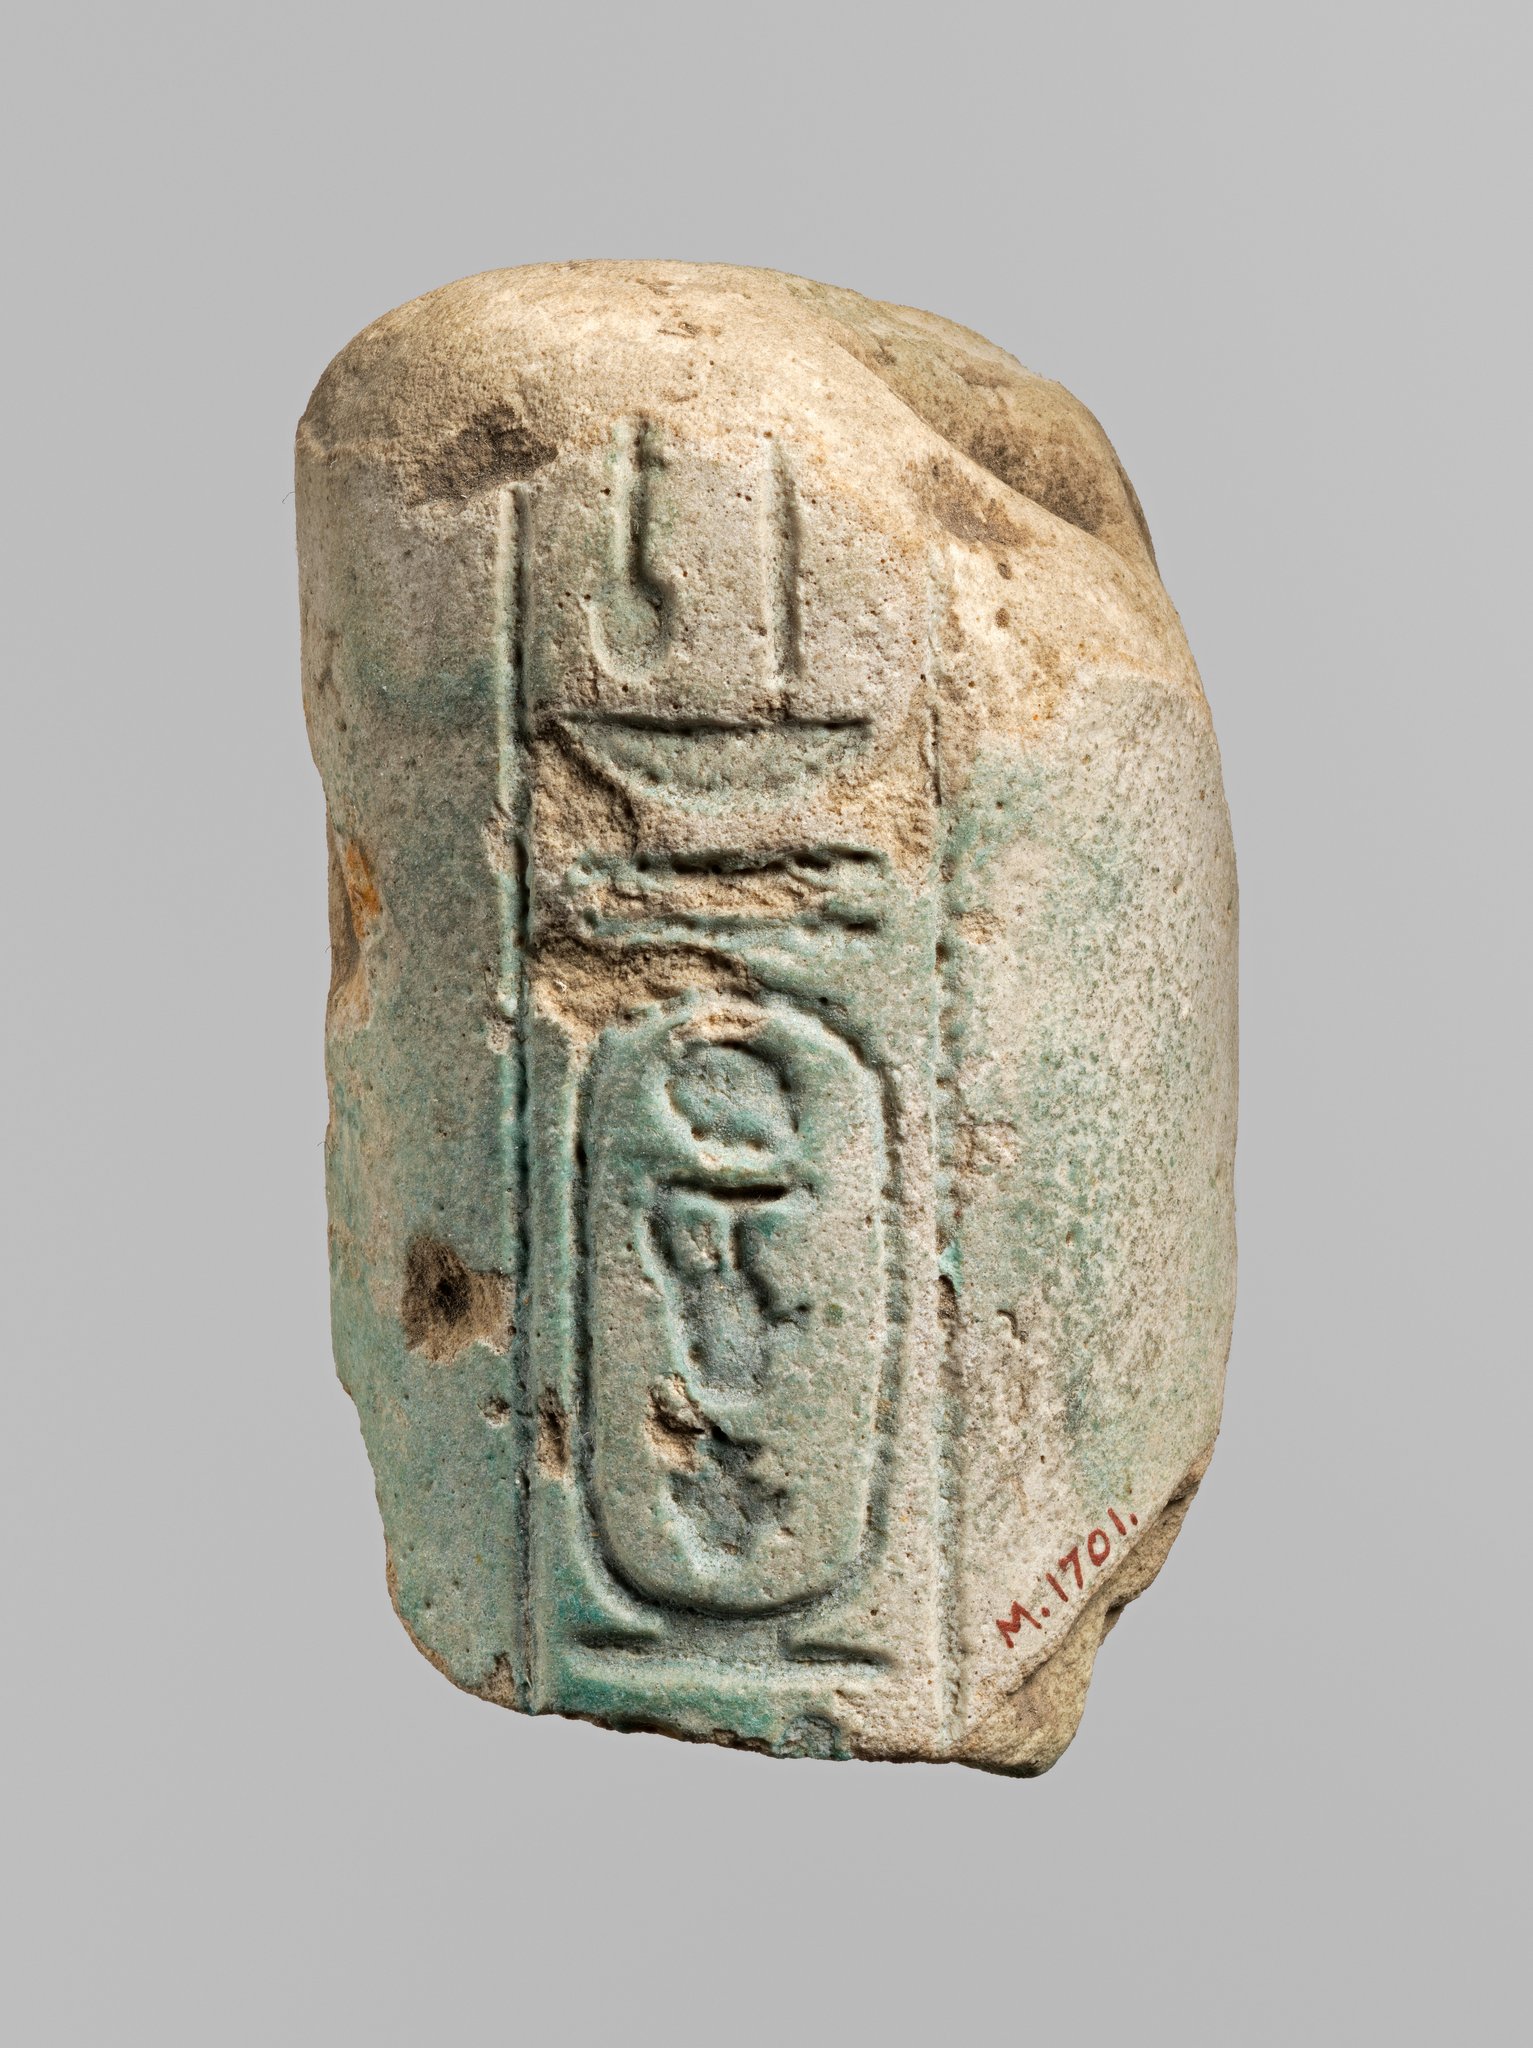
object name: music, sistrum, amasis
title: Fragment of Sistrum Handle of Amasis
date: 570-526 BCE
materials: limestone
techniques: glazing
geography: egypt